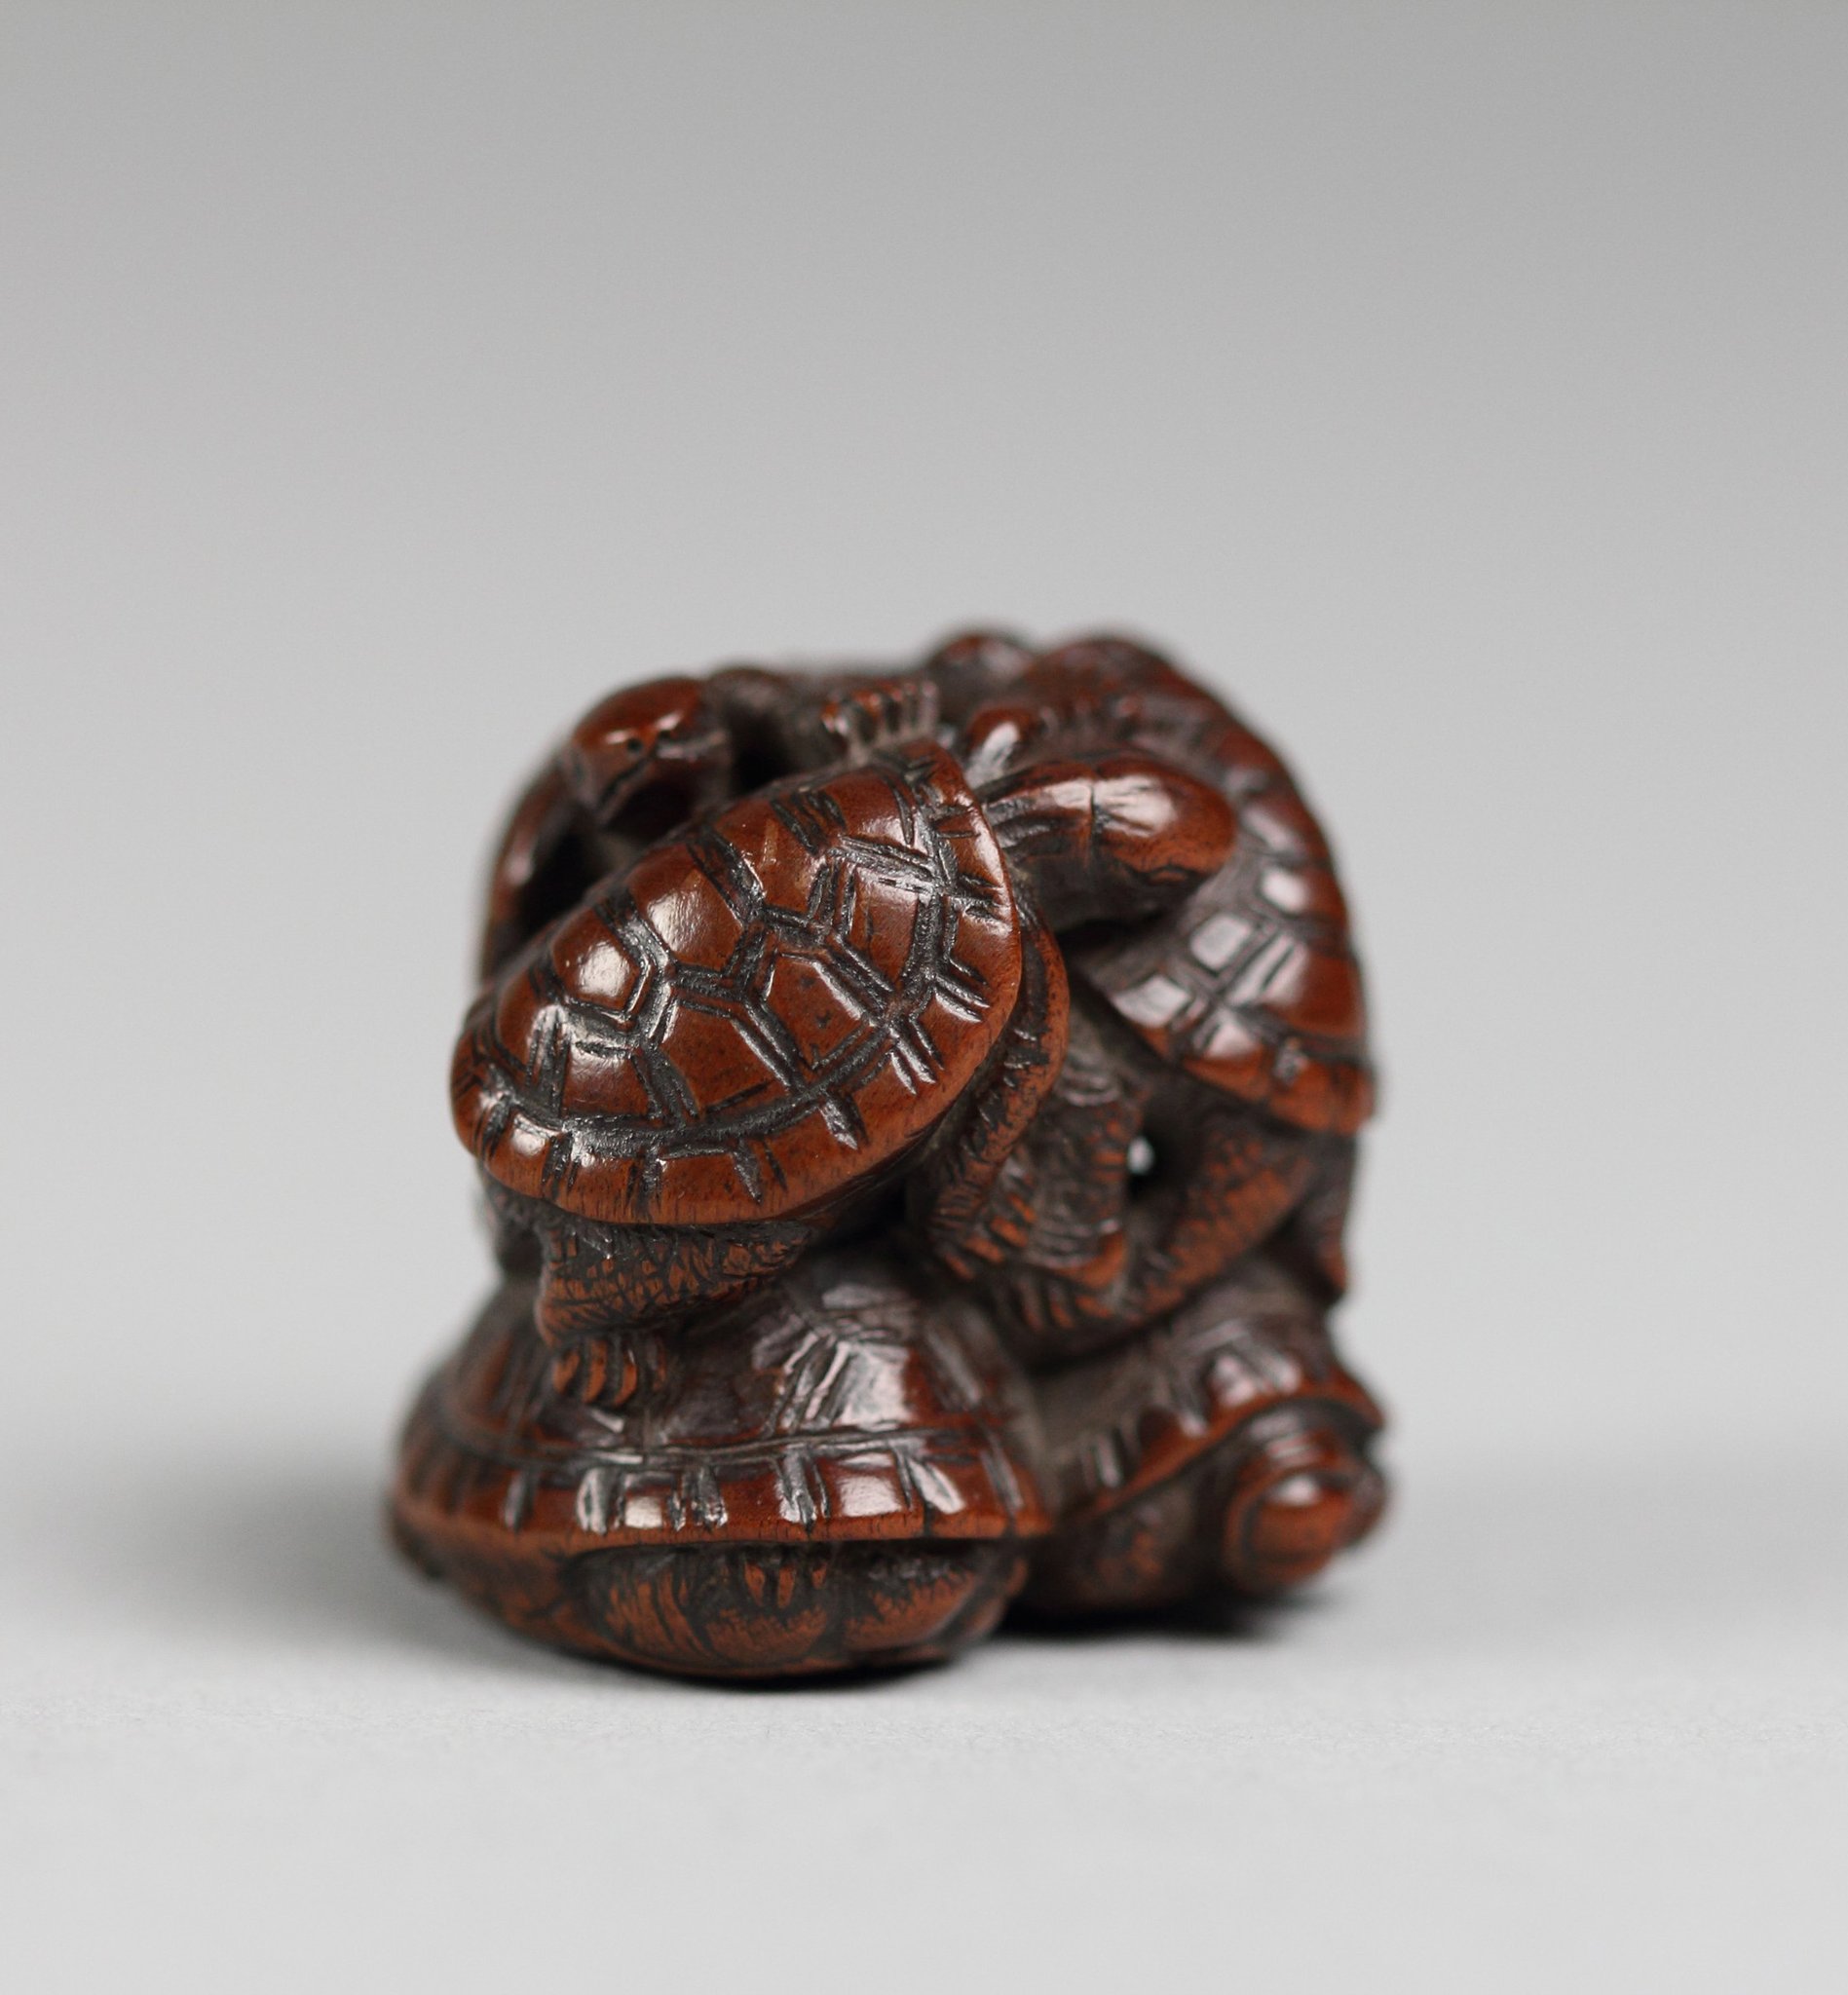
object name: netsuke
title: Netsuke in the Shape of a Pile of Turtles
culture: japanese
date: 1801-1900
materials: wood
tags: turtles